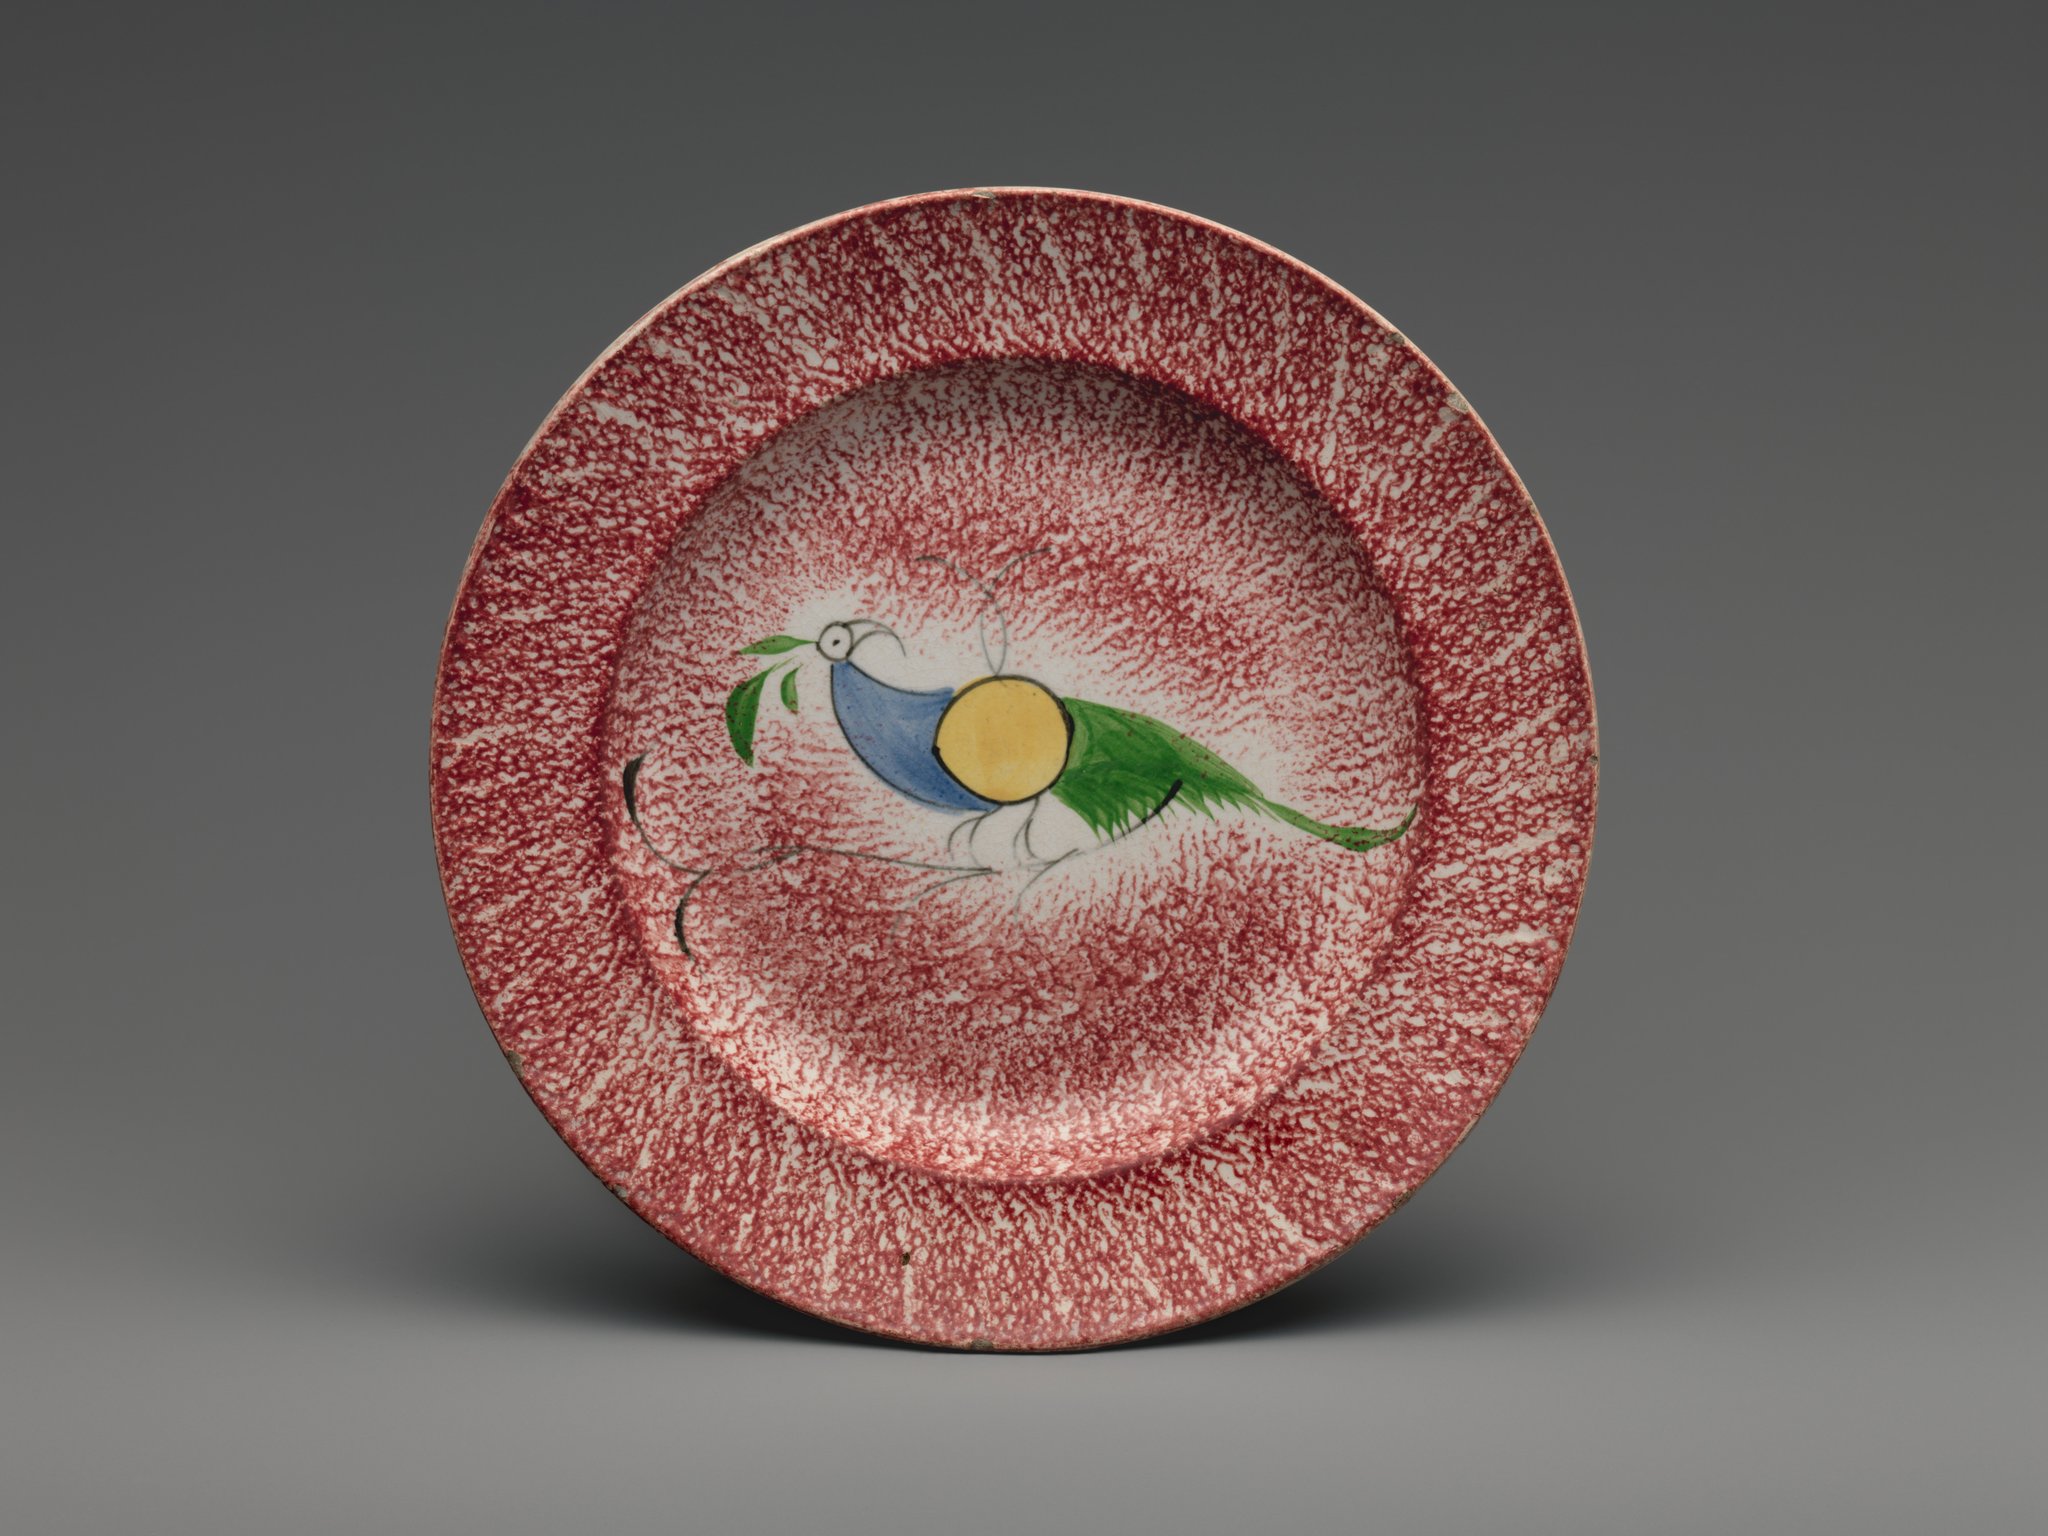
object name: plate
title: Plate with peafowl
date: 1825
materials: earthenware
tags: birds